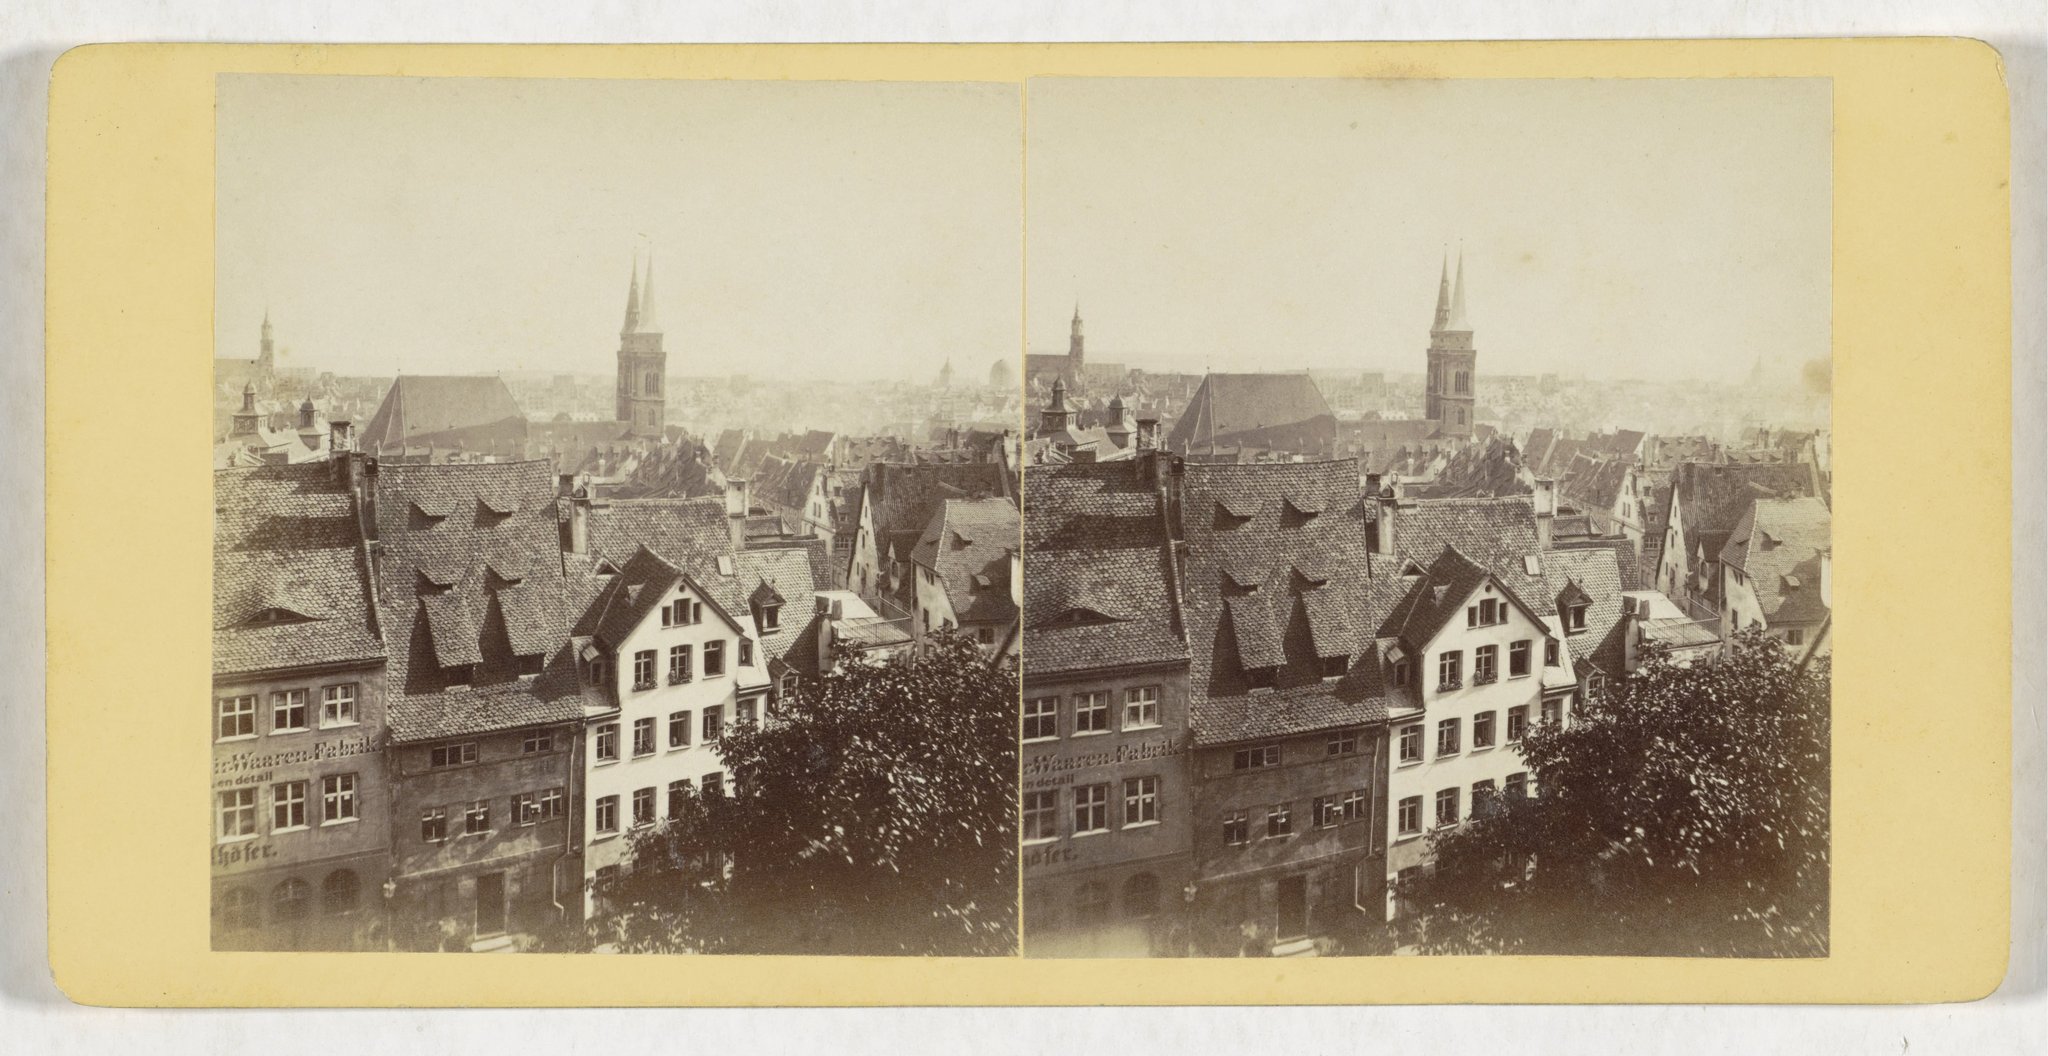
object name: stereograph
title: Ansicht von der Burg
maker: johann friedrich stiehm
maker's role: fotograaf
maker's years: 1826-1902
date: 1868-1888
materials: cardboard, paper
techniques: albumen print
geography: nuremberg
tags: city-view in general; 'veduta'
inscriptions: number: ‘No. 37.’